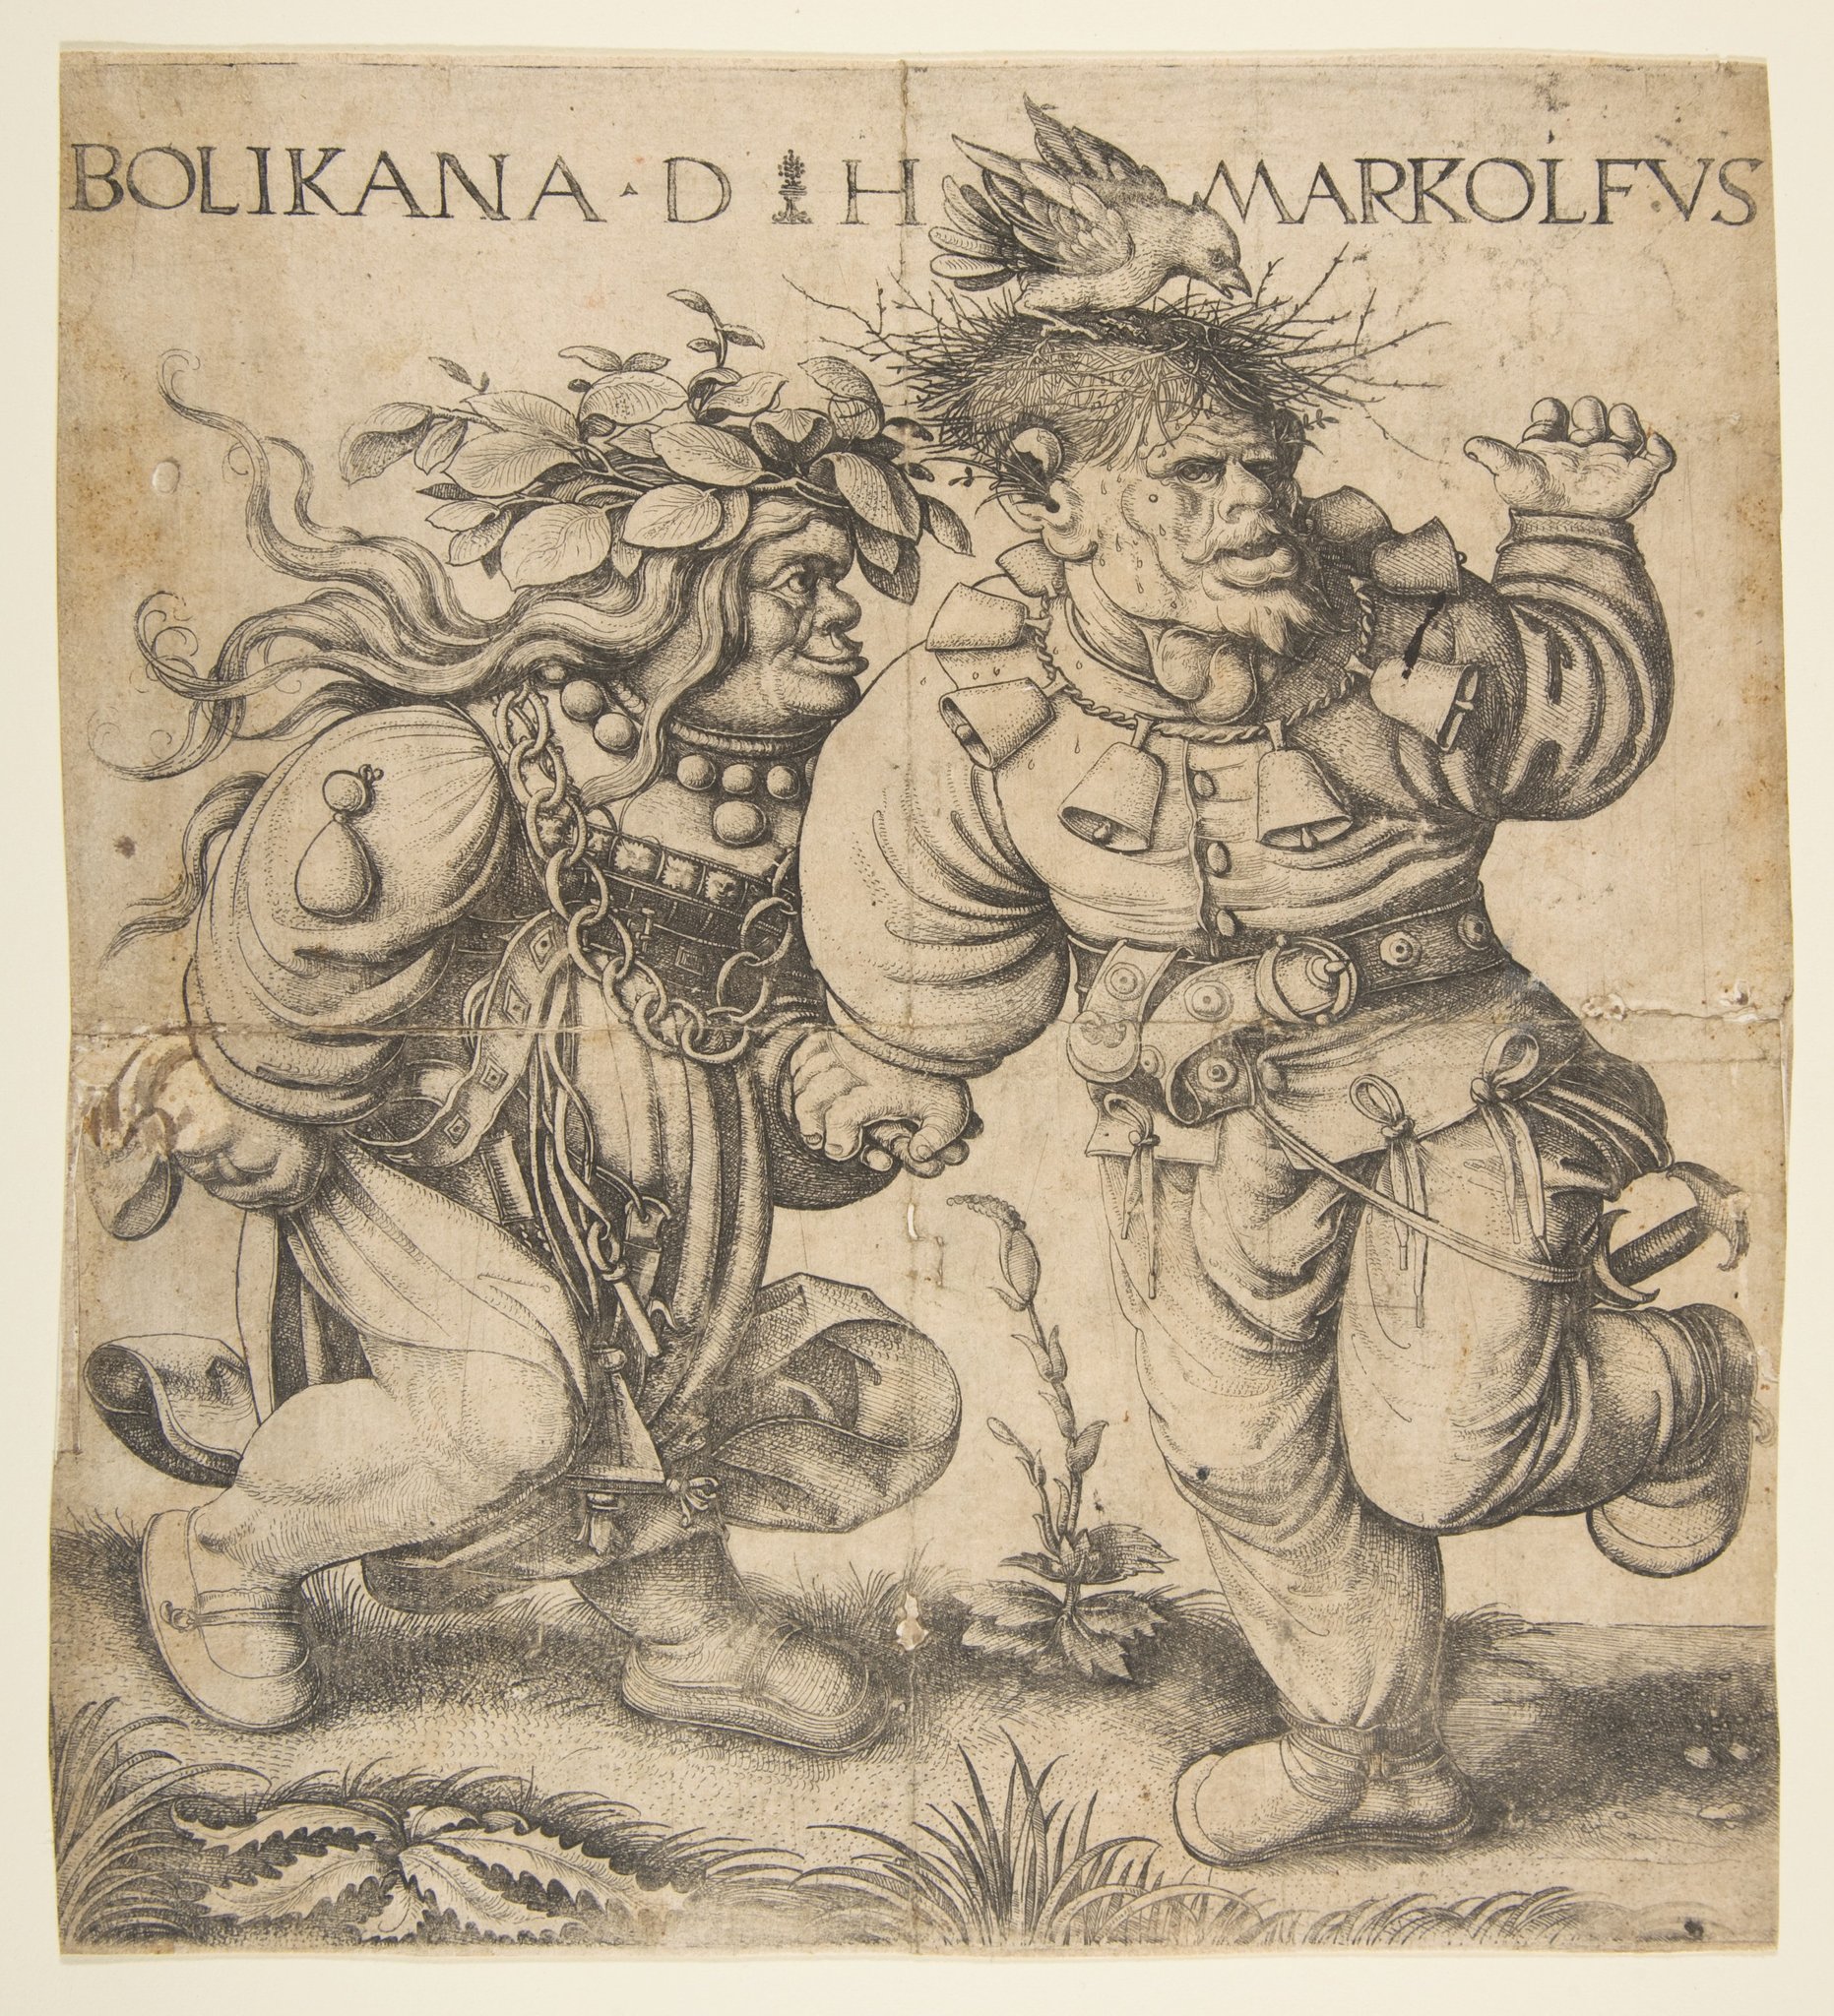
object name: print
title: Bolinka and Marcolfus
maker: daniel hopfer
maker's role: artist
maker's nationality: german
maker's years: 1470-1536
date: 1467-1533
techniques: etching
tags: men